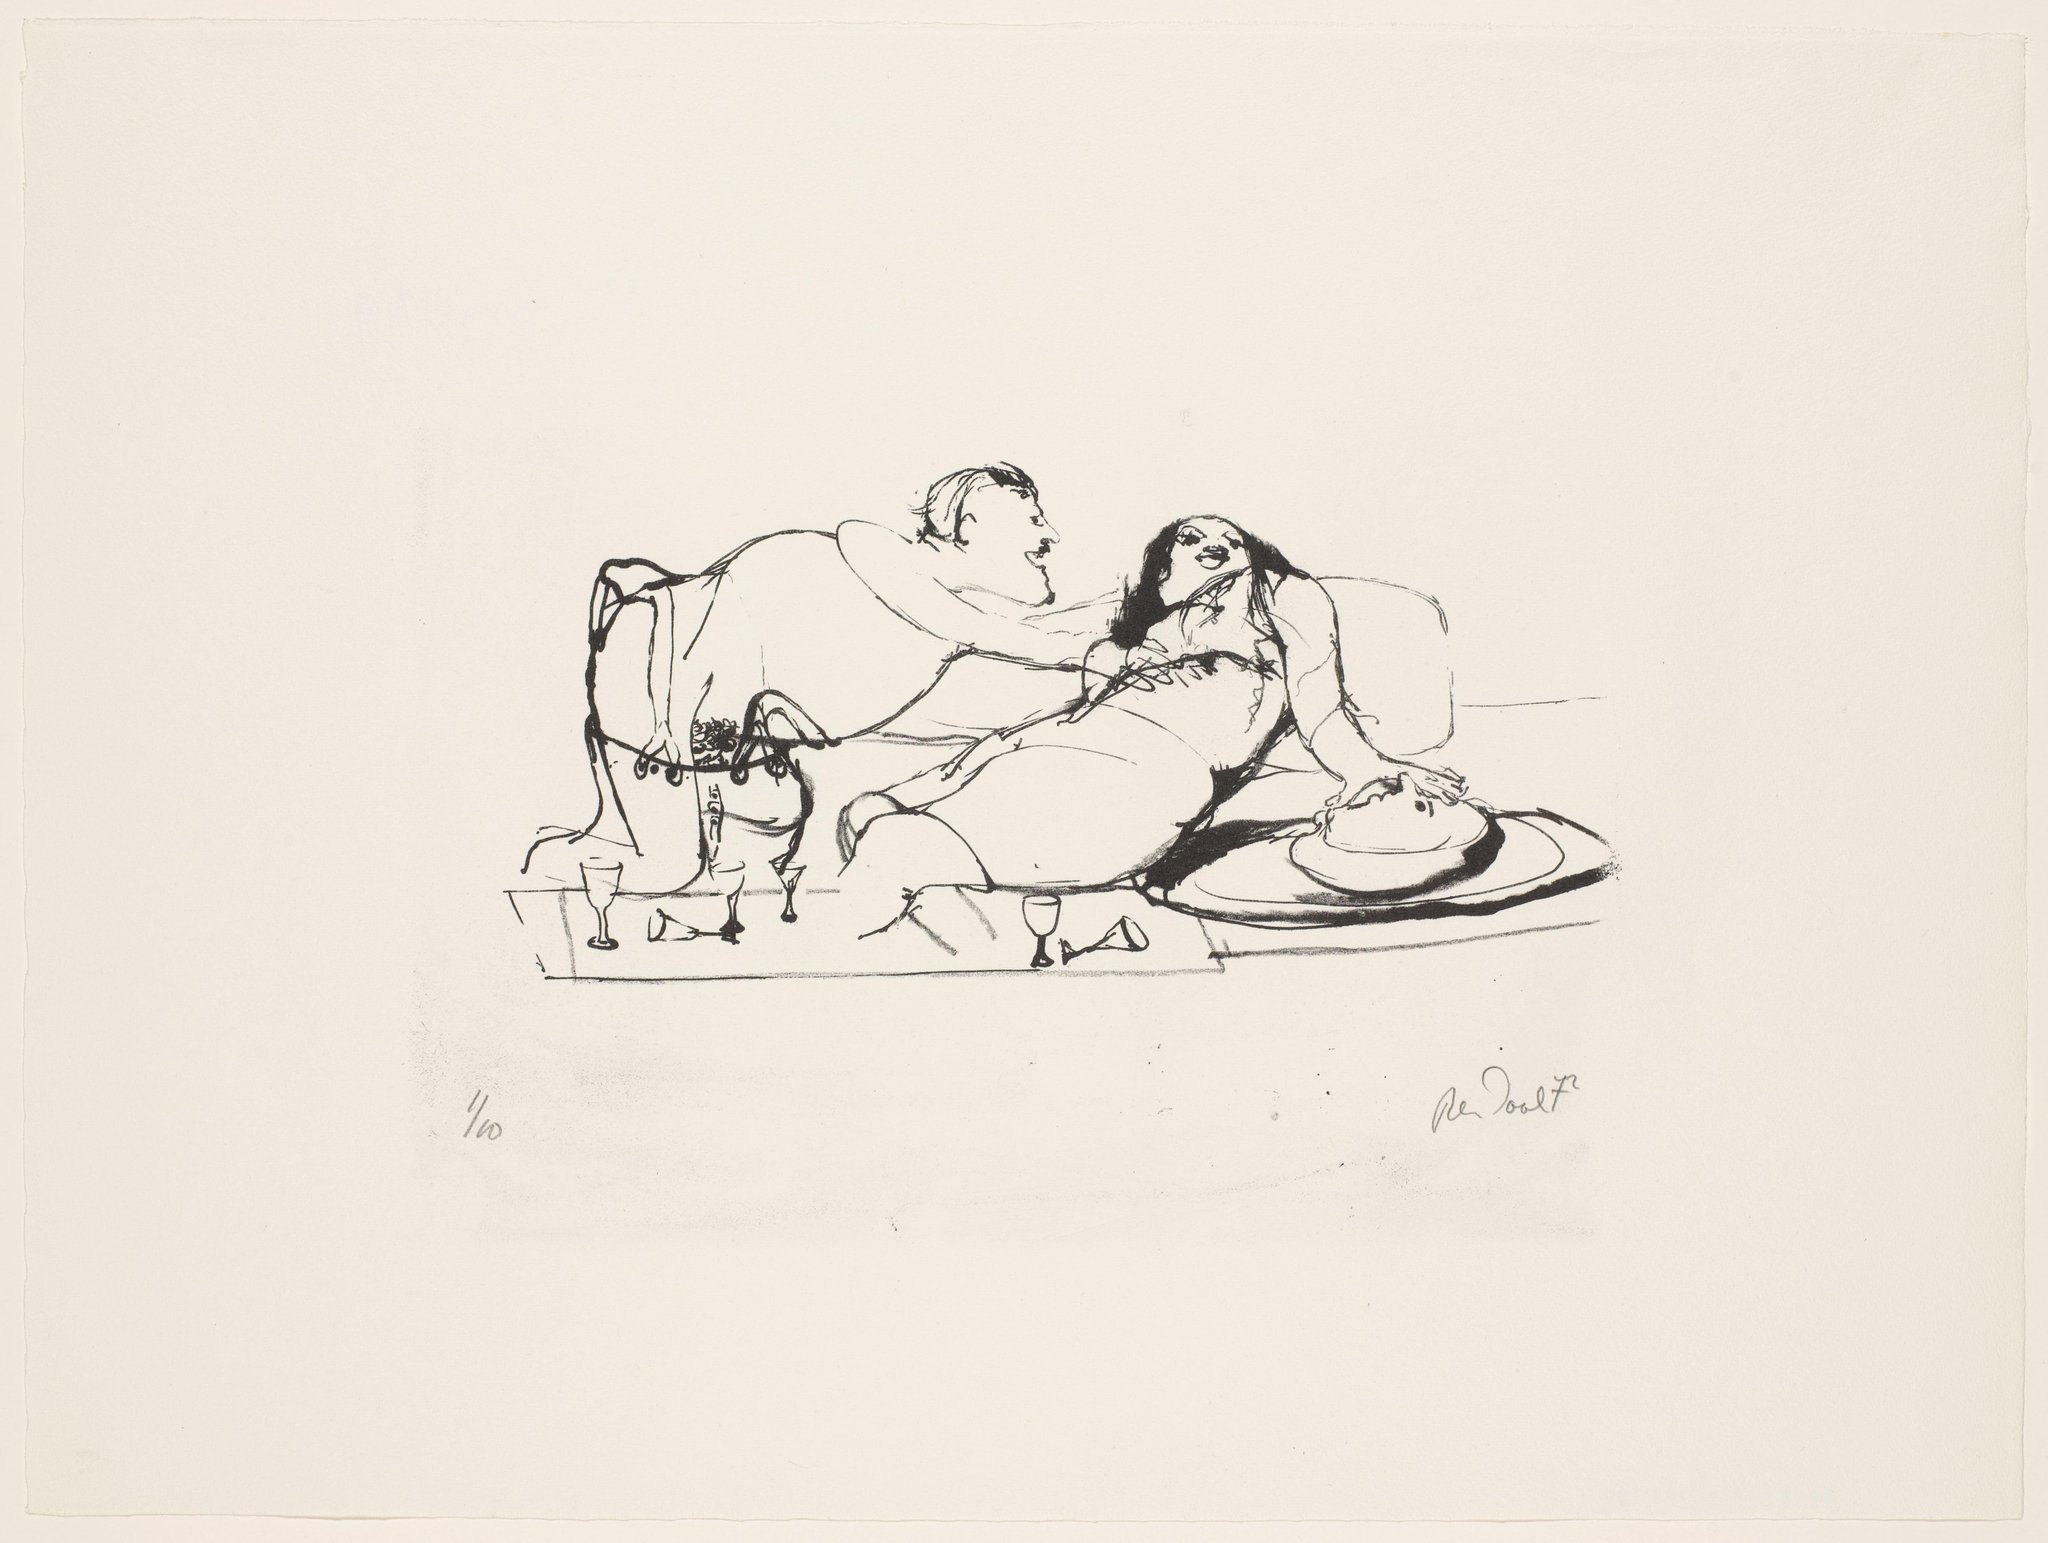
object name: print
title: Zonder titel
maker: rein dool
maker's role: draughtsman, painter, print maker, sculptor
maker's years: 1933-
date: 1972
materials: paper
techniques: lithograph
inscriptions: edition: ‘1/10’, signature and date: ‘Rein Dool '72’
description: Achteroverleunende vrouw op bank, een hand rustend op een schaal met een hoofd (Johannes de Doper), een man met een beginnende erectie met een hand op haar borst.